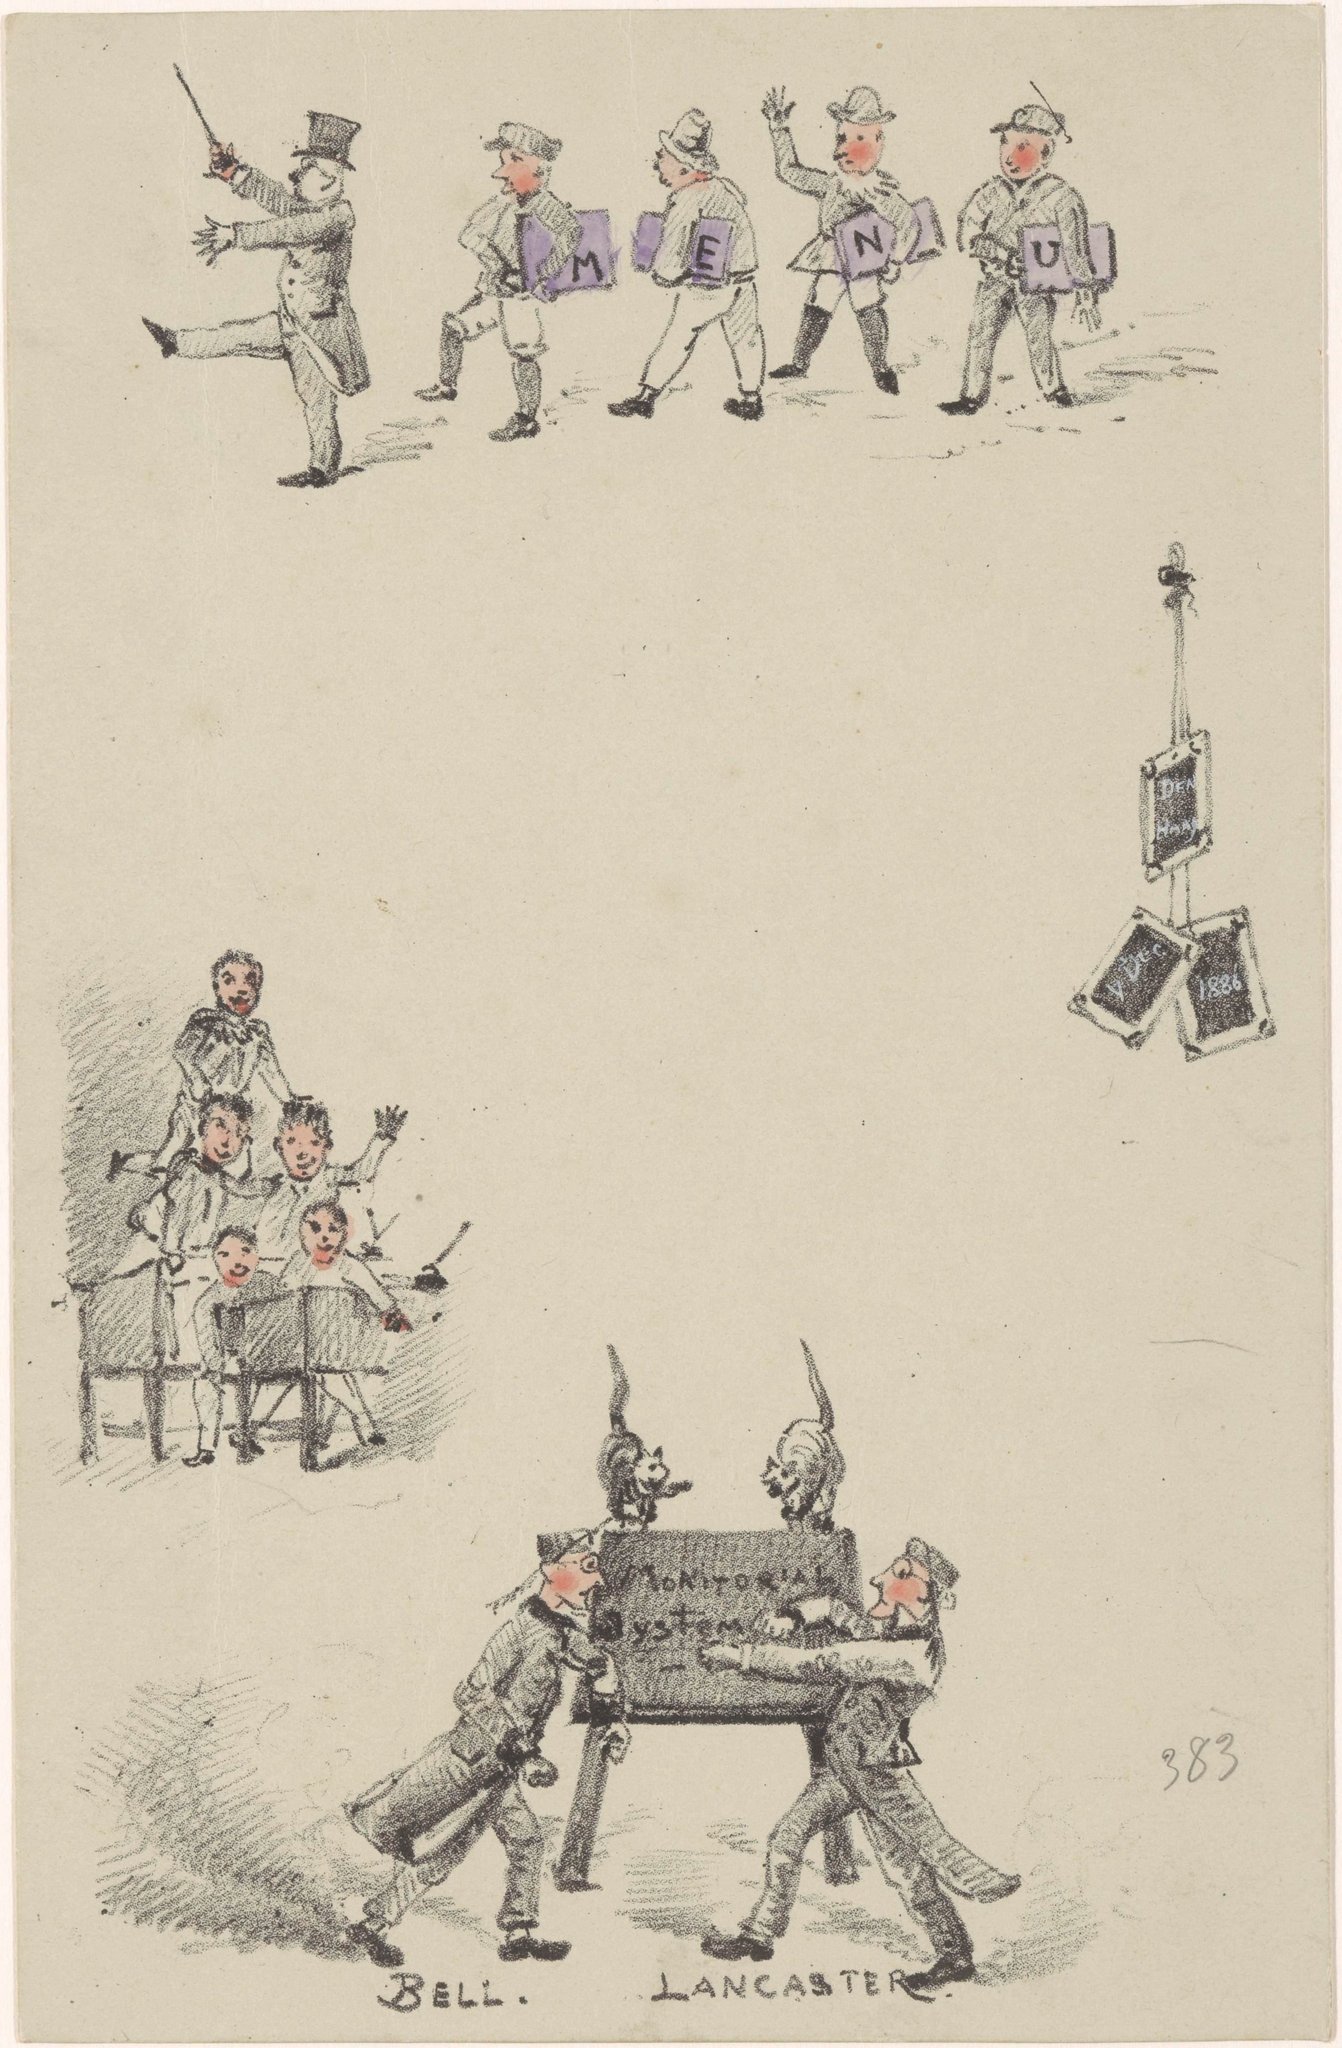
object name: print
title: Menukaart met onderwijzers en leerlingen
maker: theo van hoytema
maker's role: draughtsman, painter, print maker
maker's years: 1863-1917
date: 1886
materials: paper, watercolor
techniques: hand coloring, lithograph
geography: the hague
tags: cat, teacher and pupil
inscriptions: number: ‘383’, collector's mark: Lugt 2228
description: Onderaan twee onderwijzers 'Bell' en 'Lancaster' voor een schoolbord met katten. Rechts hangen drie leistenen met daarop plaatsnaam en datering. Links schoolkinderen.